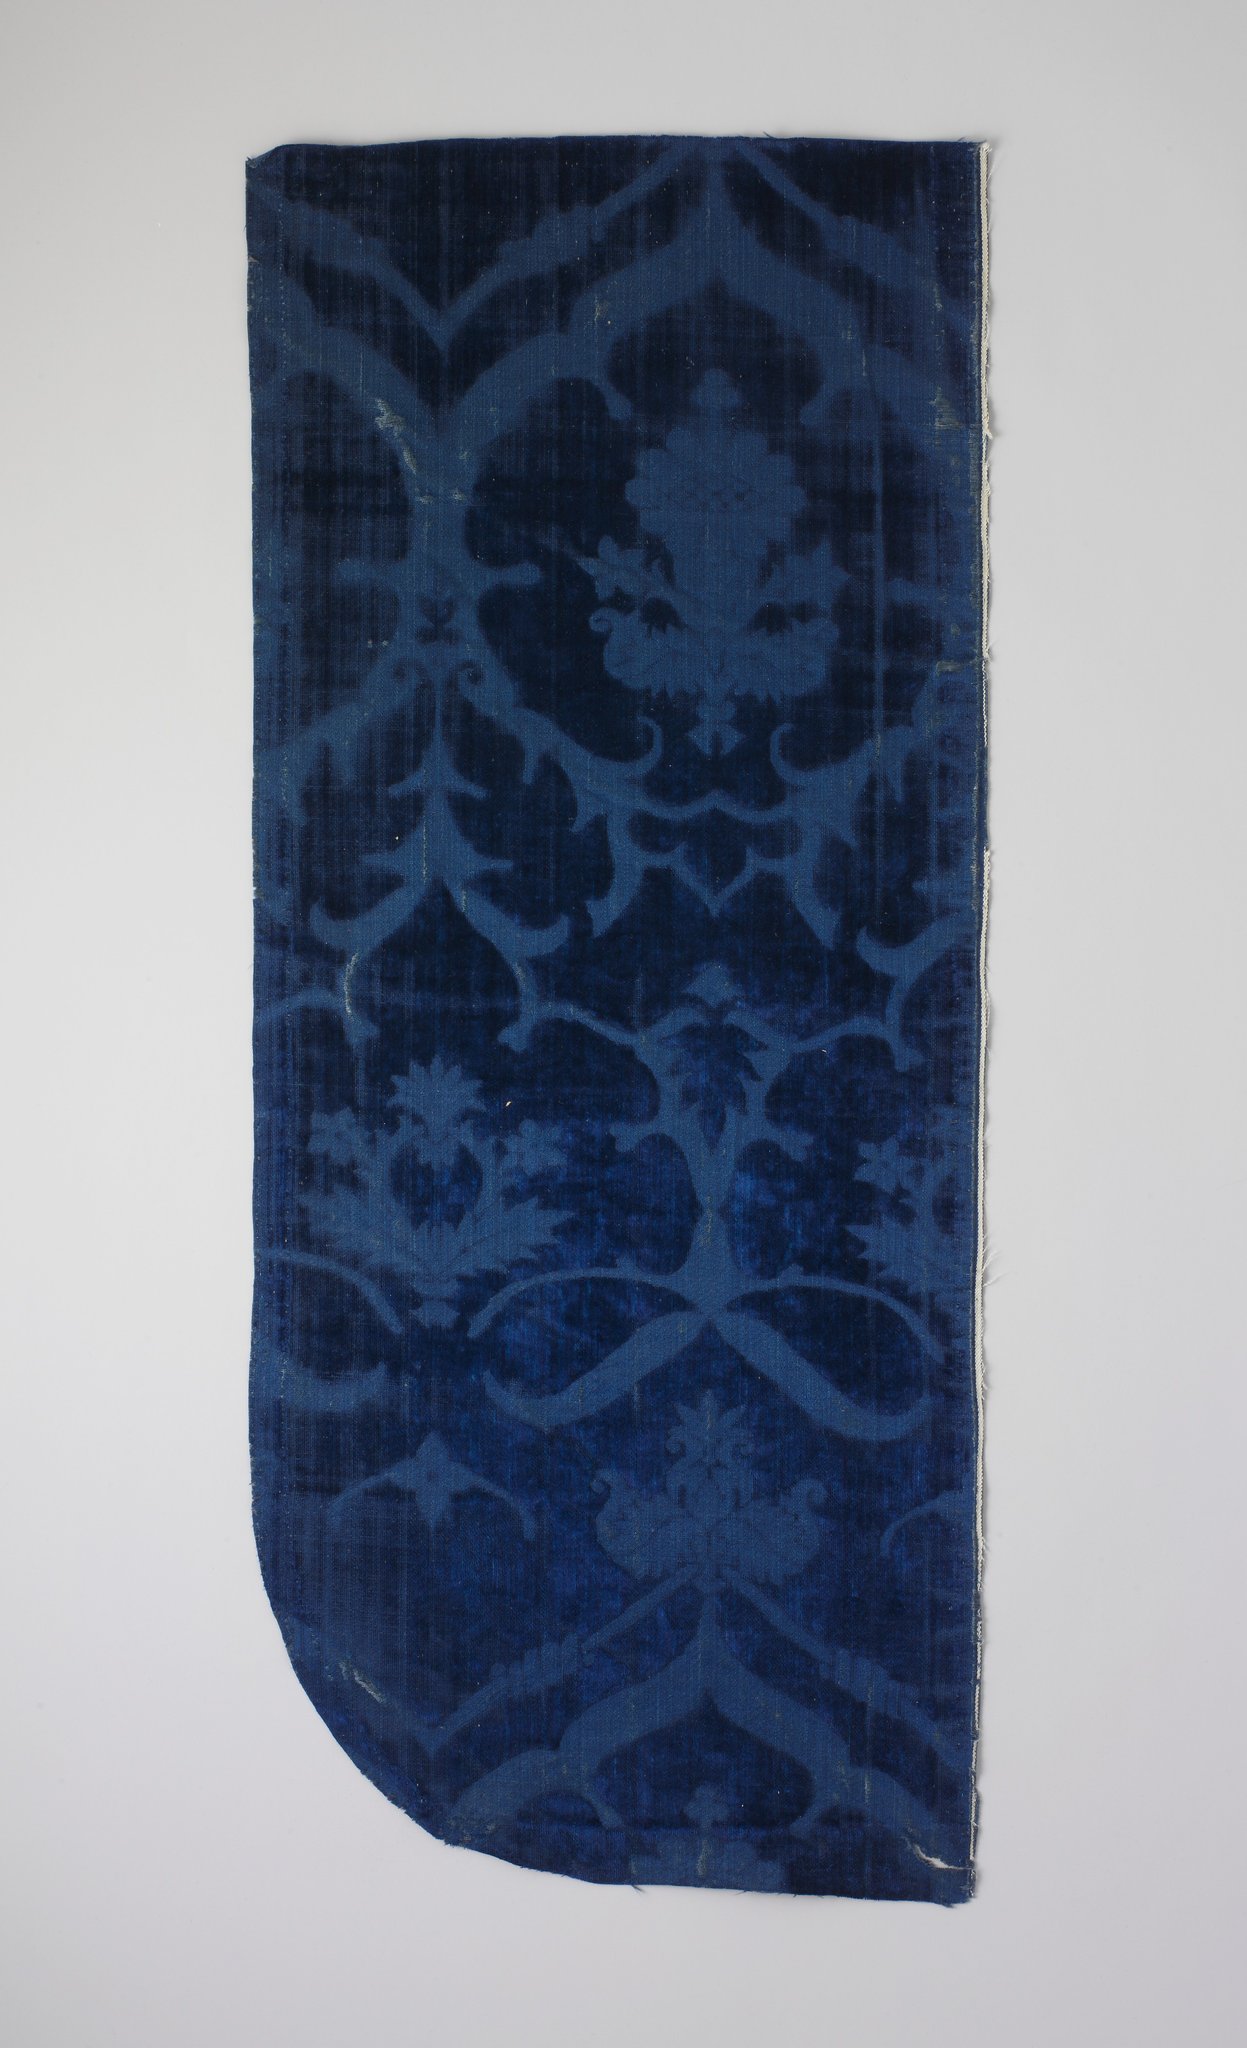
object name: piece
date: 1451-1500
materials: silk